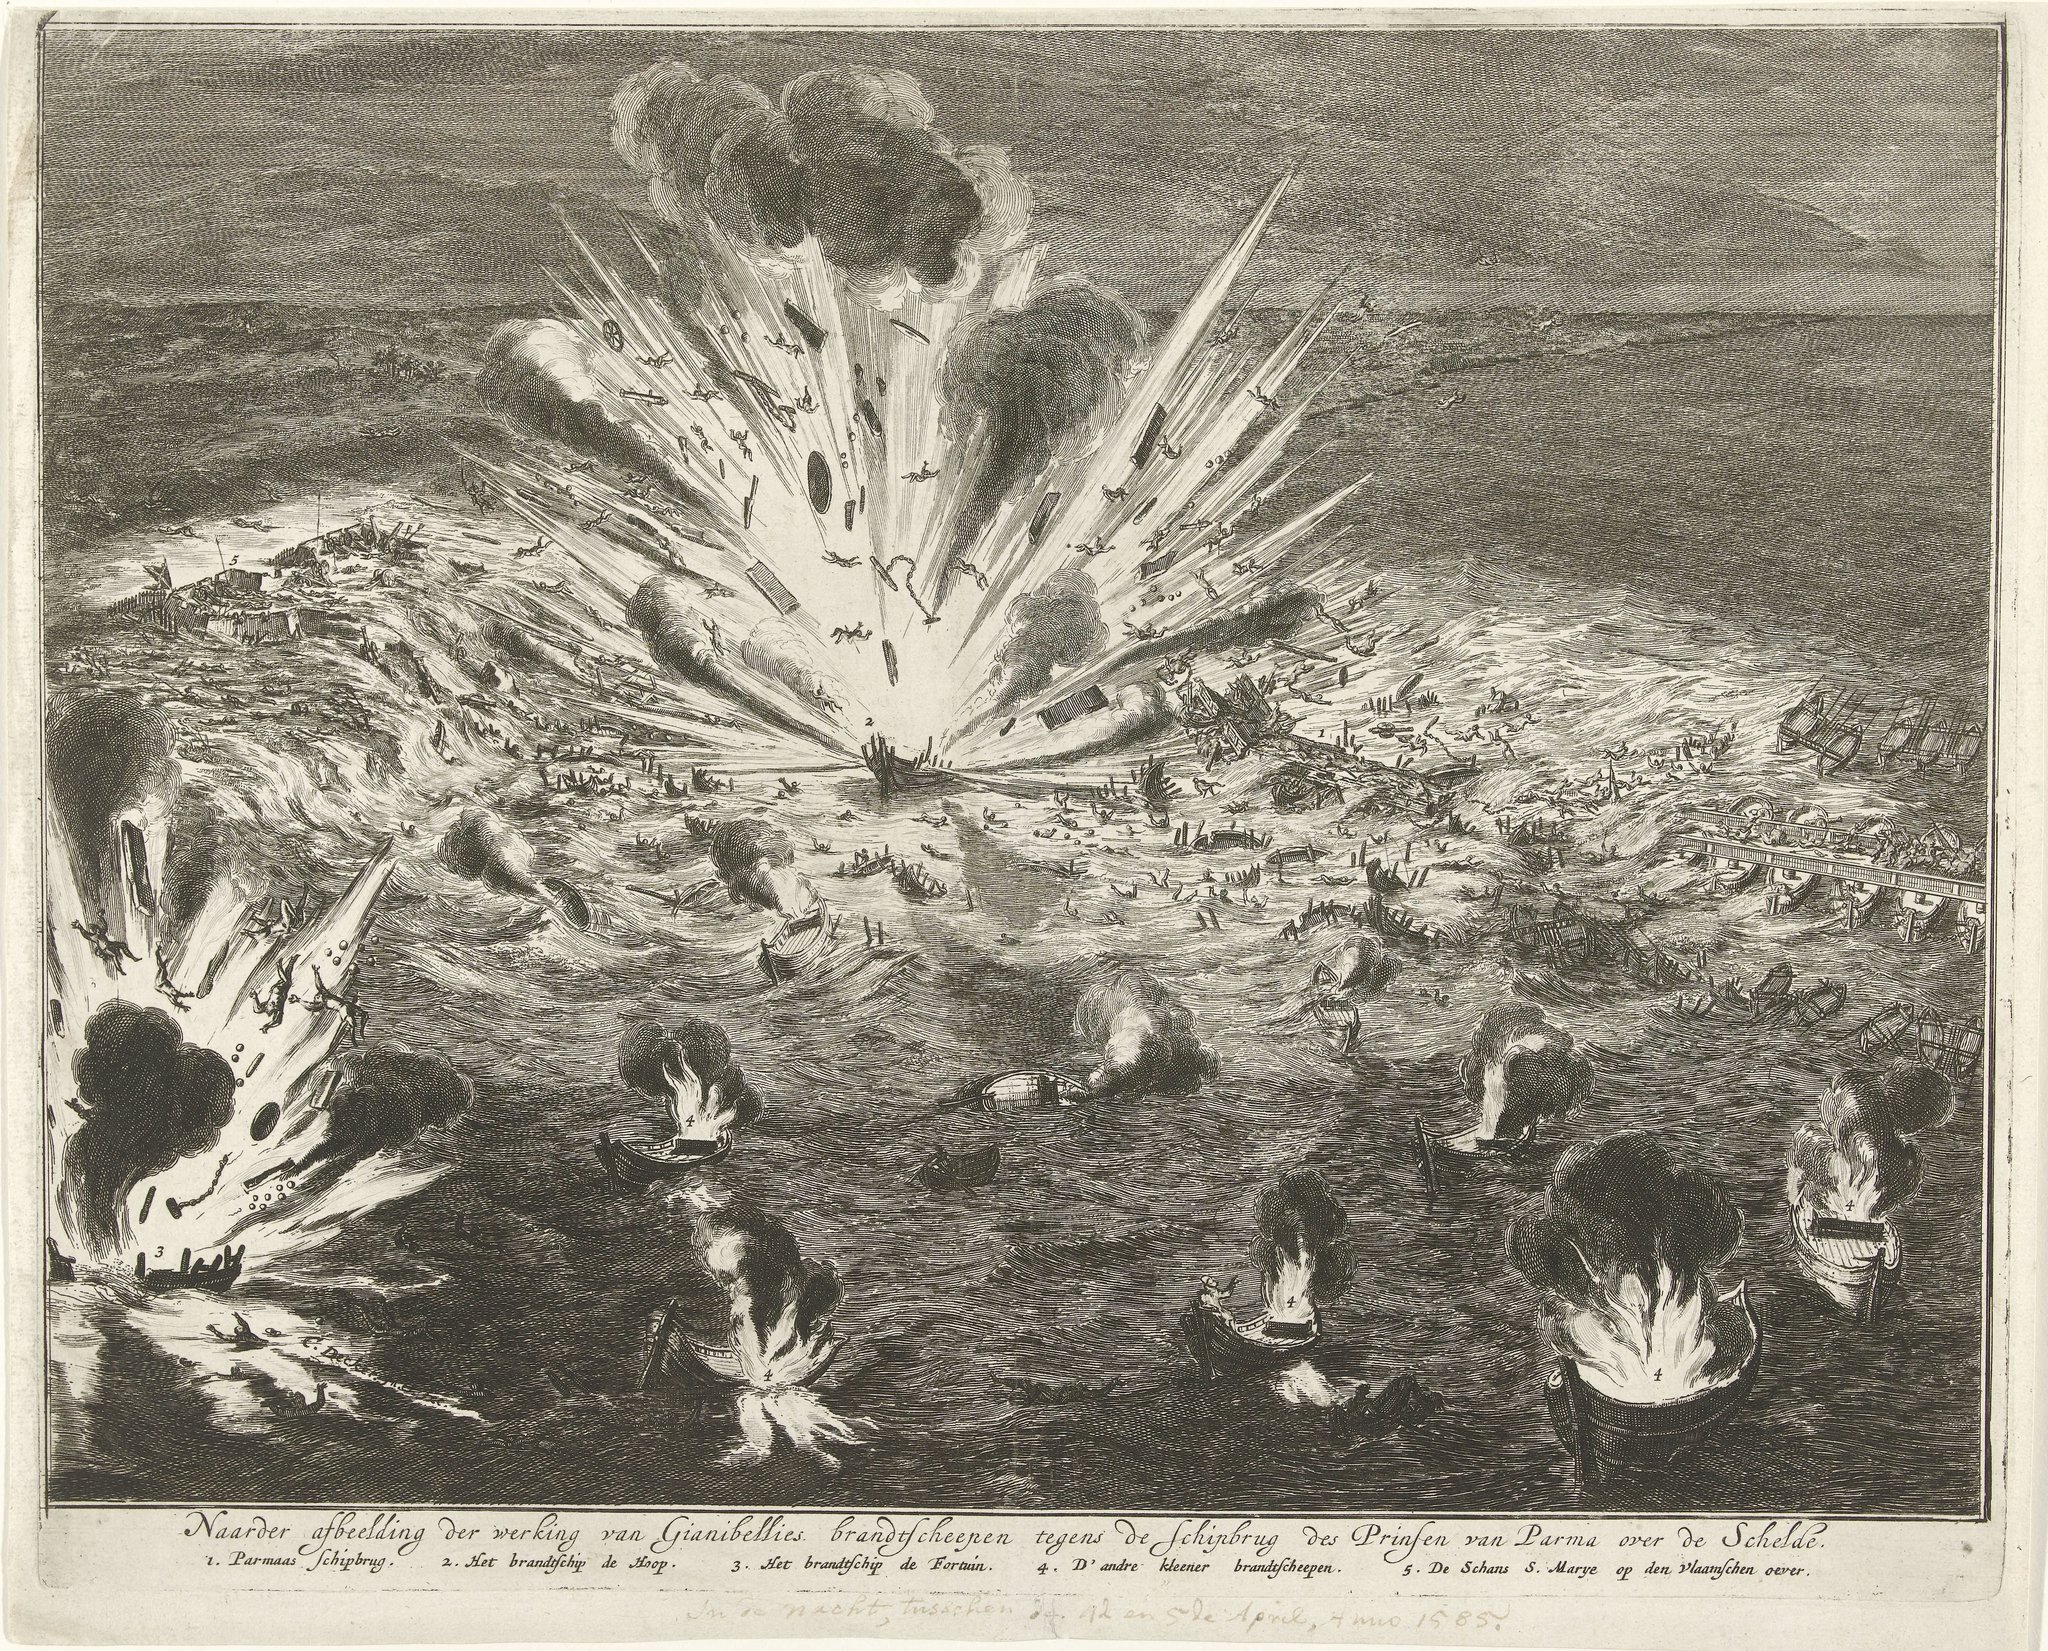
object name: print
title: Naarder afbeelding der werking van Gianibellies brandtscheepen tegens de schipbrug des prinsen van Parma over de Schelde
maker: coenraet decker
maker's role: print maker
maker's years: 1650-1685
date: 1677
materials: paper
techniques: engraving, etching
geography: amsterdam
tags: alessandro farnese (landvoogd van de nederlanden en hertog van parma en piacenza), pontoon bridge, antwerp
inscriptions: inscription: ‘In de nacht, tusschen den 4de en 5de April, Anno 1585’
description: Huidige staat van prent ook gebruikt in: P.C. Hoofts Nederlandsche historien, seedert de ooverdraght der heerschappye van kaizar Karel den Vyfden op koning Philips zynen zoon, tot het einde der landtvooghdye des graven van Leicester. 3e druk. 2 delen. Amsterdam: Johan van Someren, Abraham Wolfgang en Hendrik en Dirk Boom, 1677, dl. 2, p. 1002-1003. Voor tweede staat zie: RP-P-1944-2281. Voor derde staat zie: RP-P-OB-79.984.